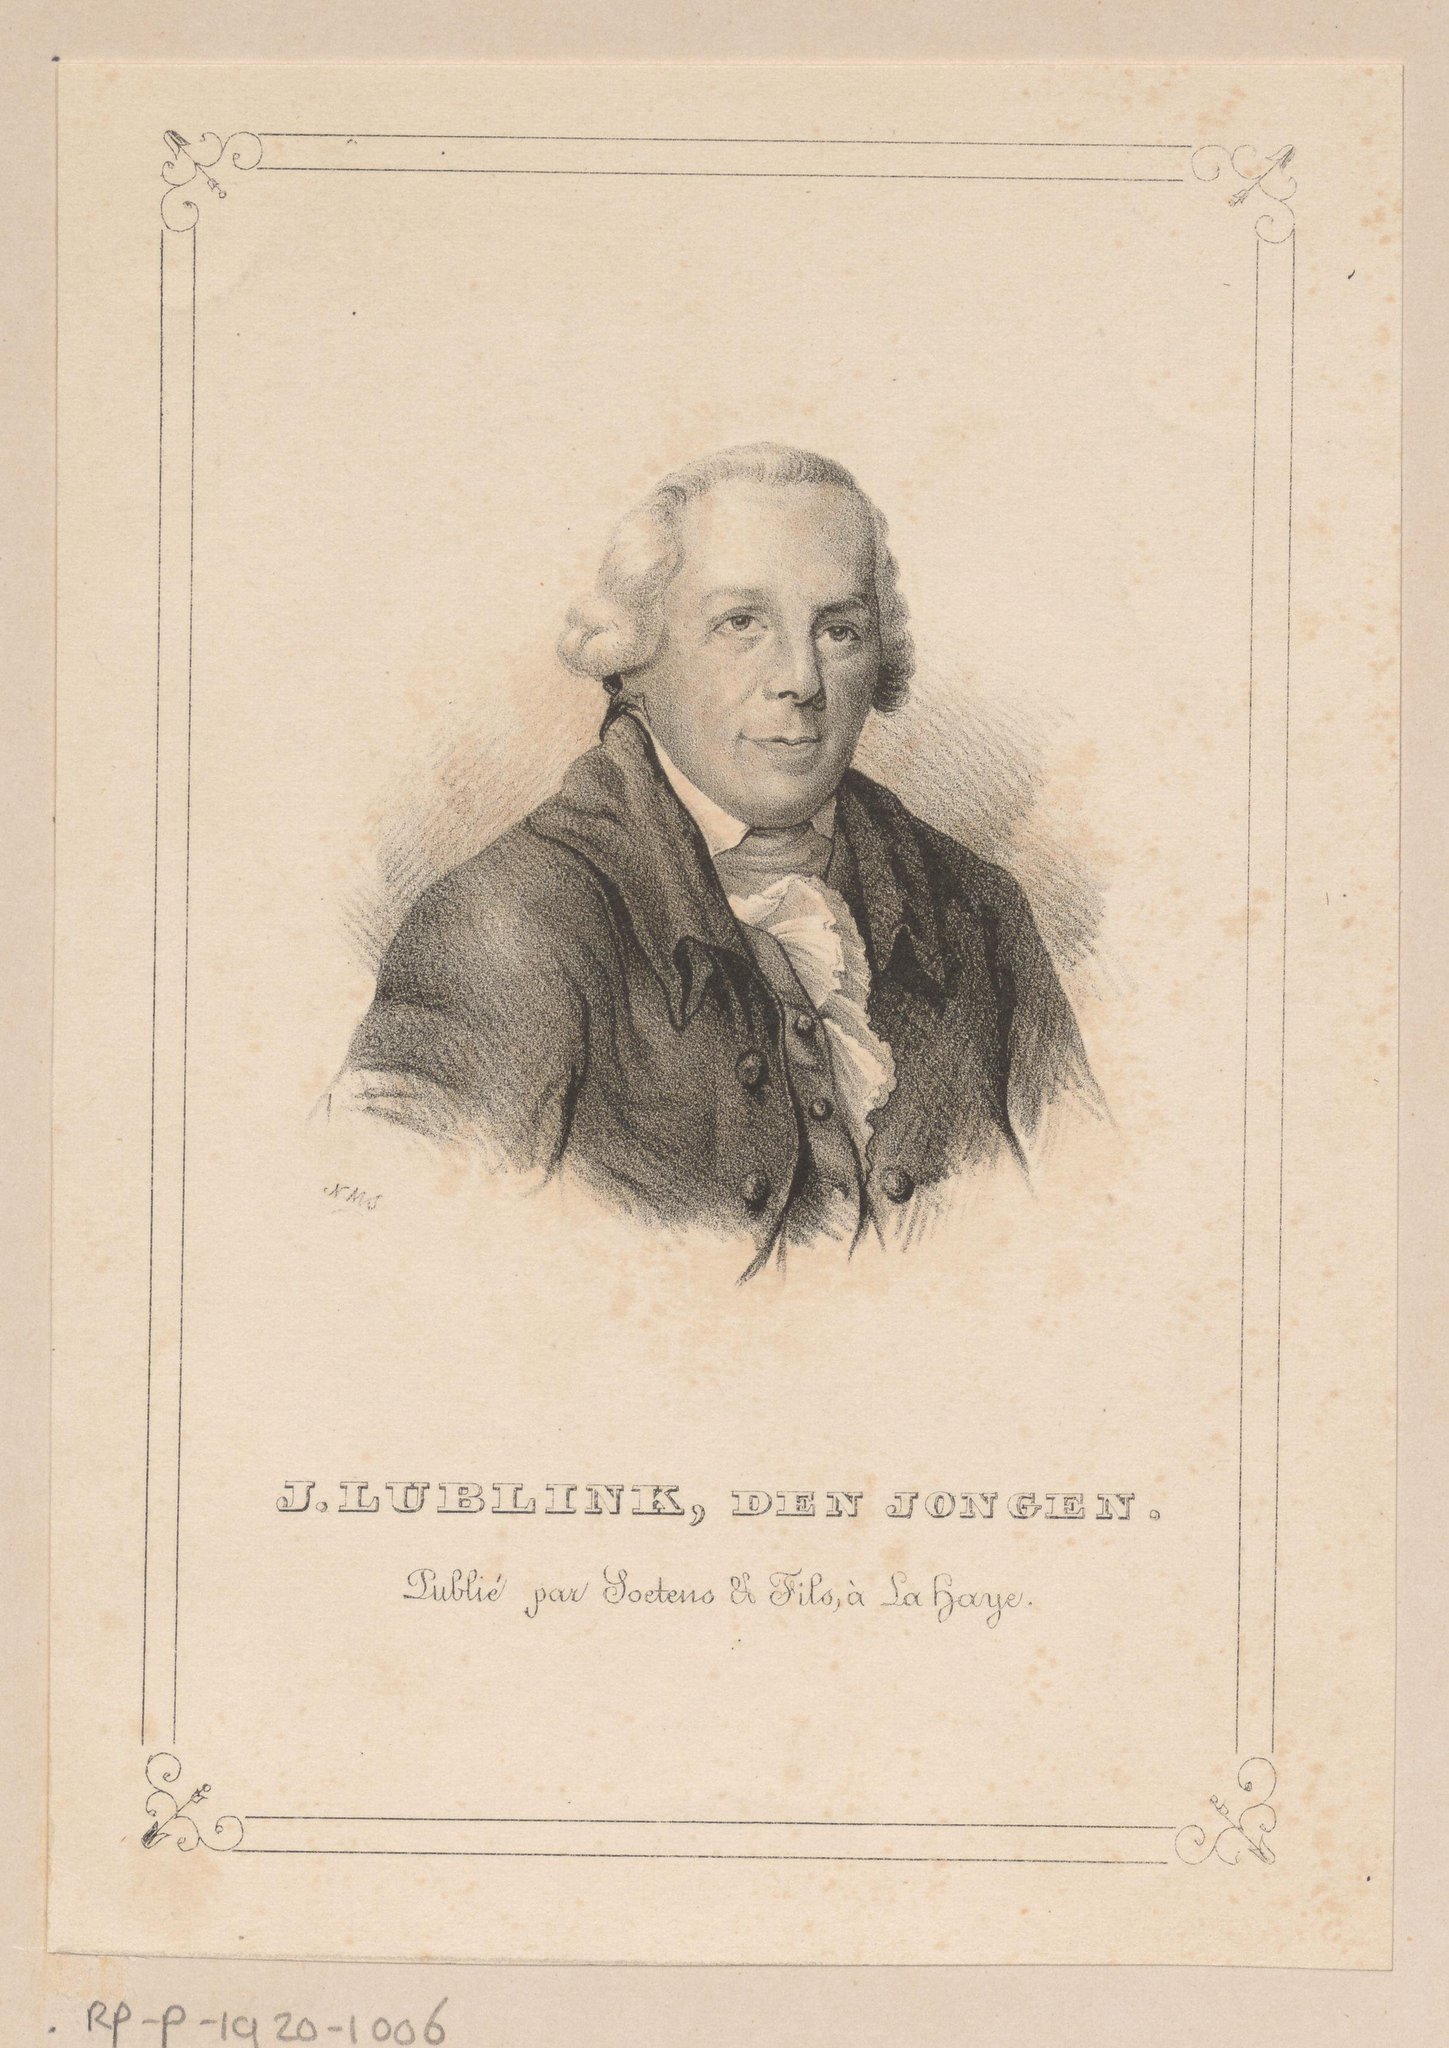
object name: print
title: Serie portretten door Soetens & Fils uit 1838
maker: nicolaas martinus schild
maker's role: draughtsman, print maker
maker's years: 1822-1840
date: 1837-1840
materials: paper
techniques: lithograph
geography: the hague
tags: amsterdam, utrecht, johannes lublink (de jonge), historical persons, portrait of a writer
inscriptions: collector's mark: Lugt 2228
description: Deze prent maakte deel uit van een serie uitgegeven door Soetens et Fils omstreeks 1838, opgedragen aan de Prins van Oranje. In de 'Prospectus en Inteekenlijst' stond vermeld dat het zal bestaan uit een onbepaald aantal portretten, waarvan er drie of vier per maand verschijnen. Zie Van Someren.